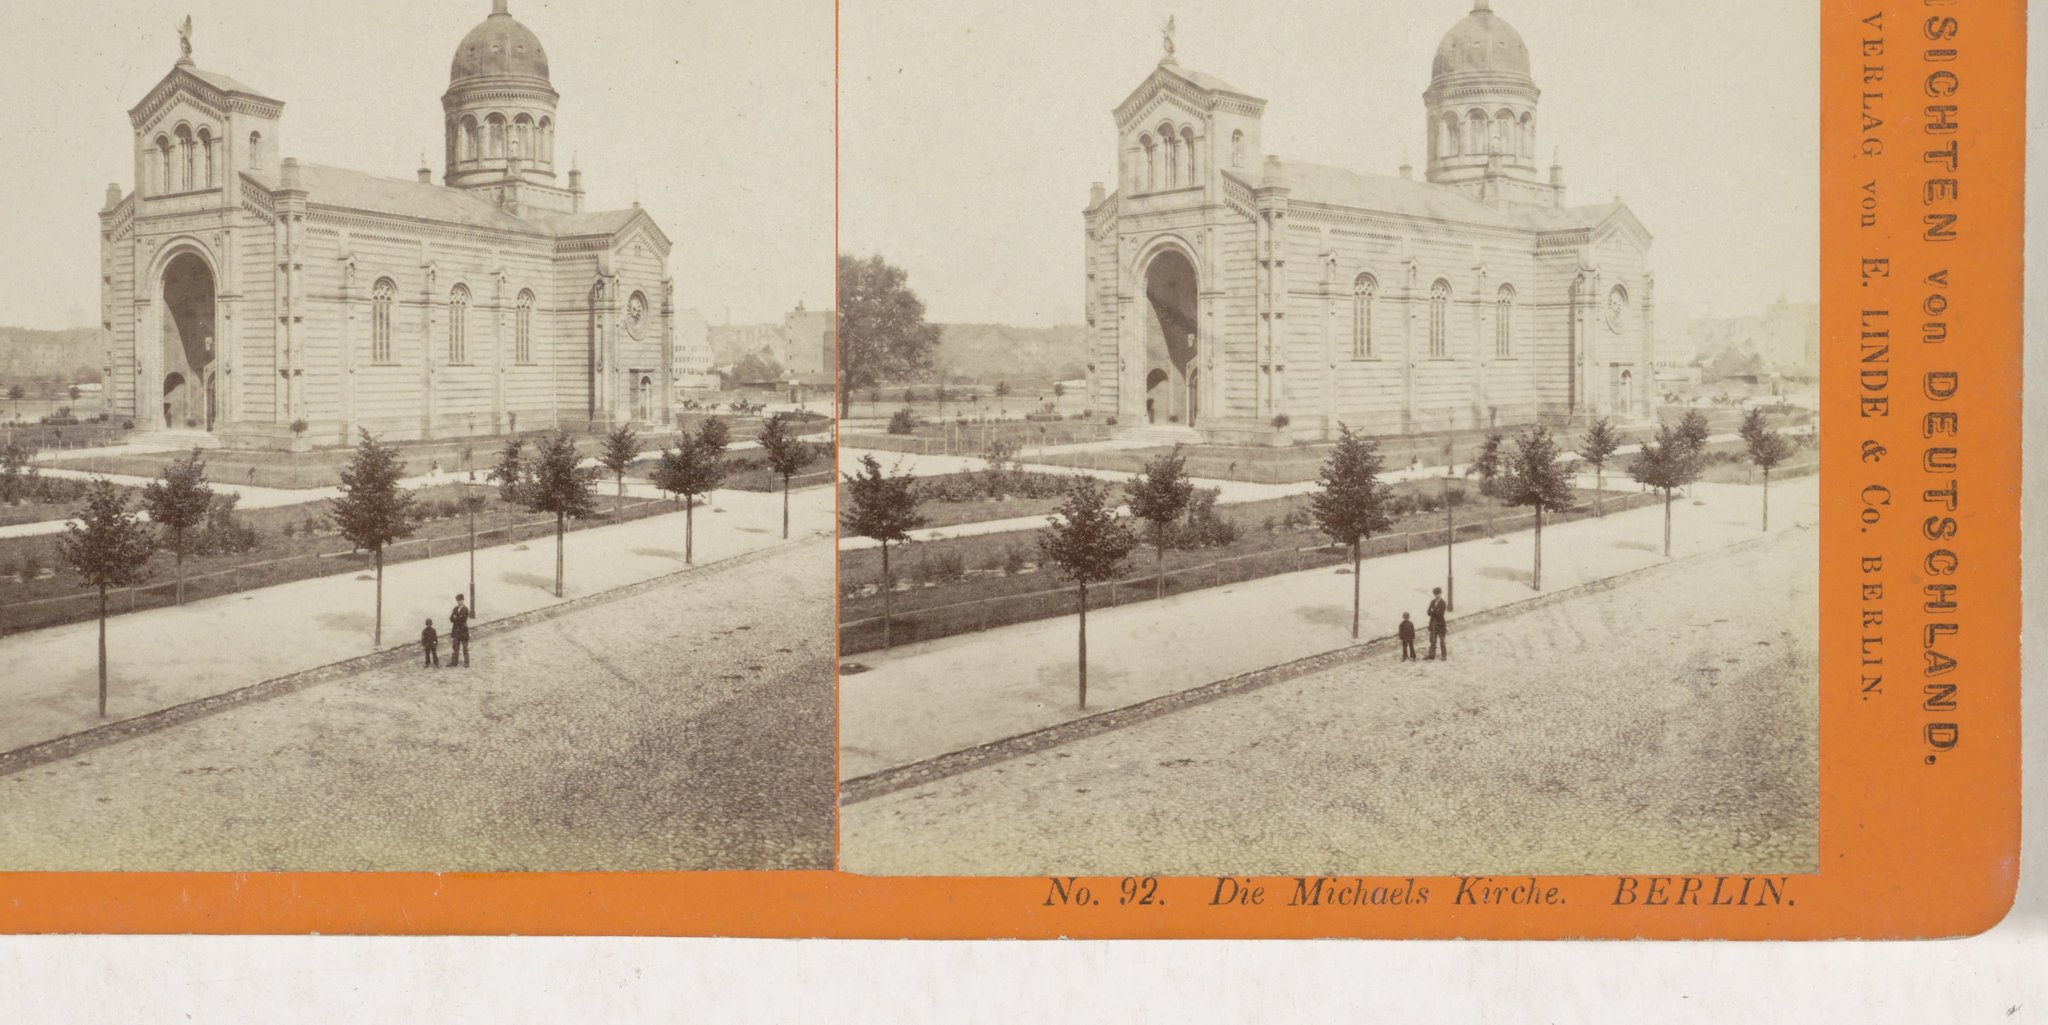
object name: stereograph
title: Die Michaels Kirche. Berlin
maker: johann friedrich stiehm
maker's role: fotograaf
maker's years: 1826-1902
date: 1868-1870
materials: cardboard, paper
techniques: albumen print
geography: sint-michaëlkerk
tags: roman catholic church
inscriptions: number: ‘No. 92.’